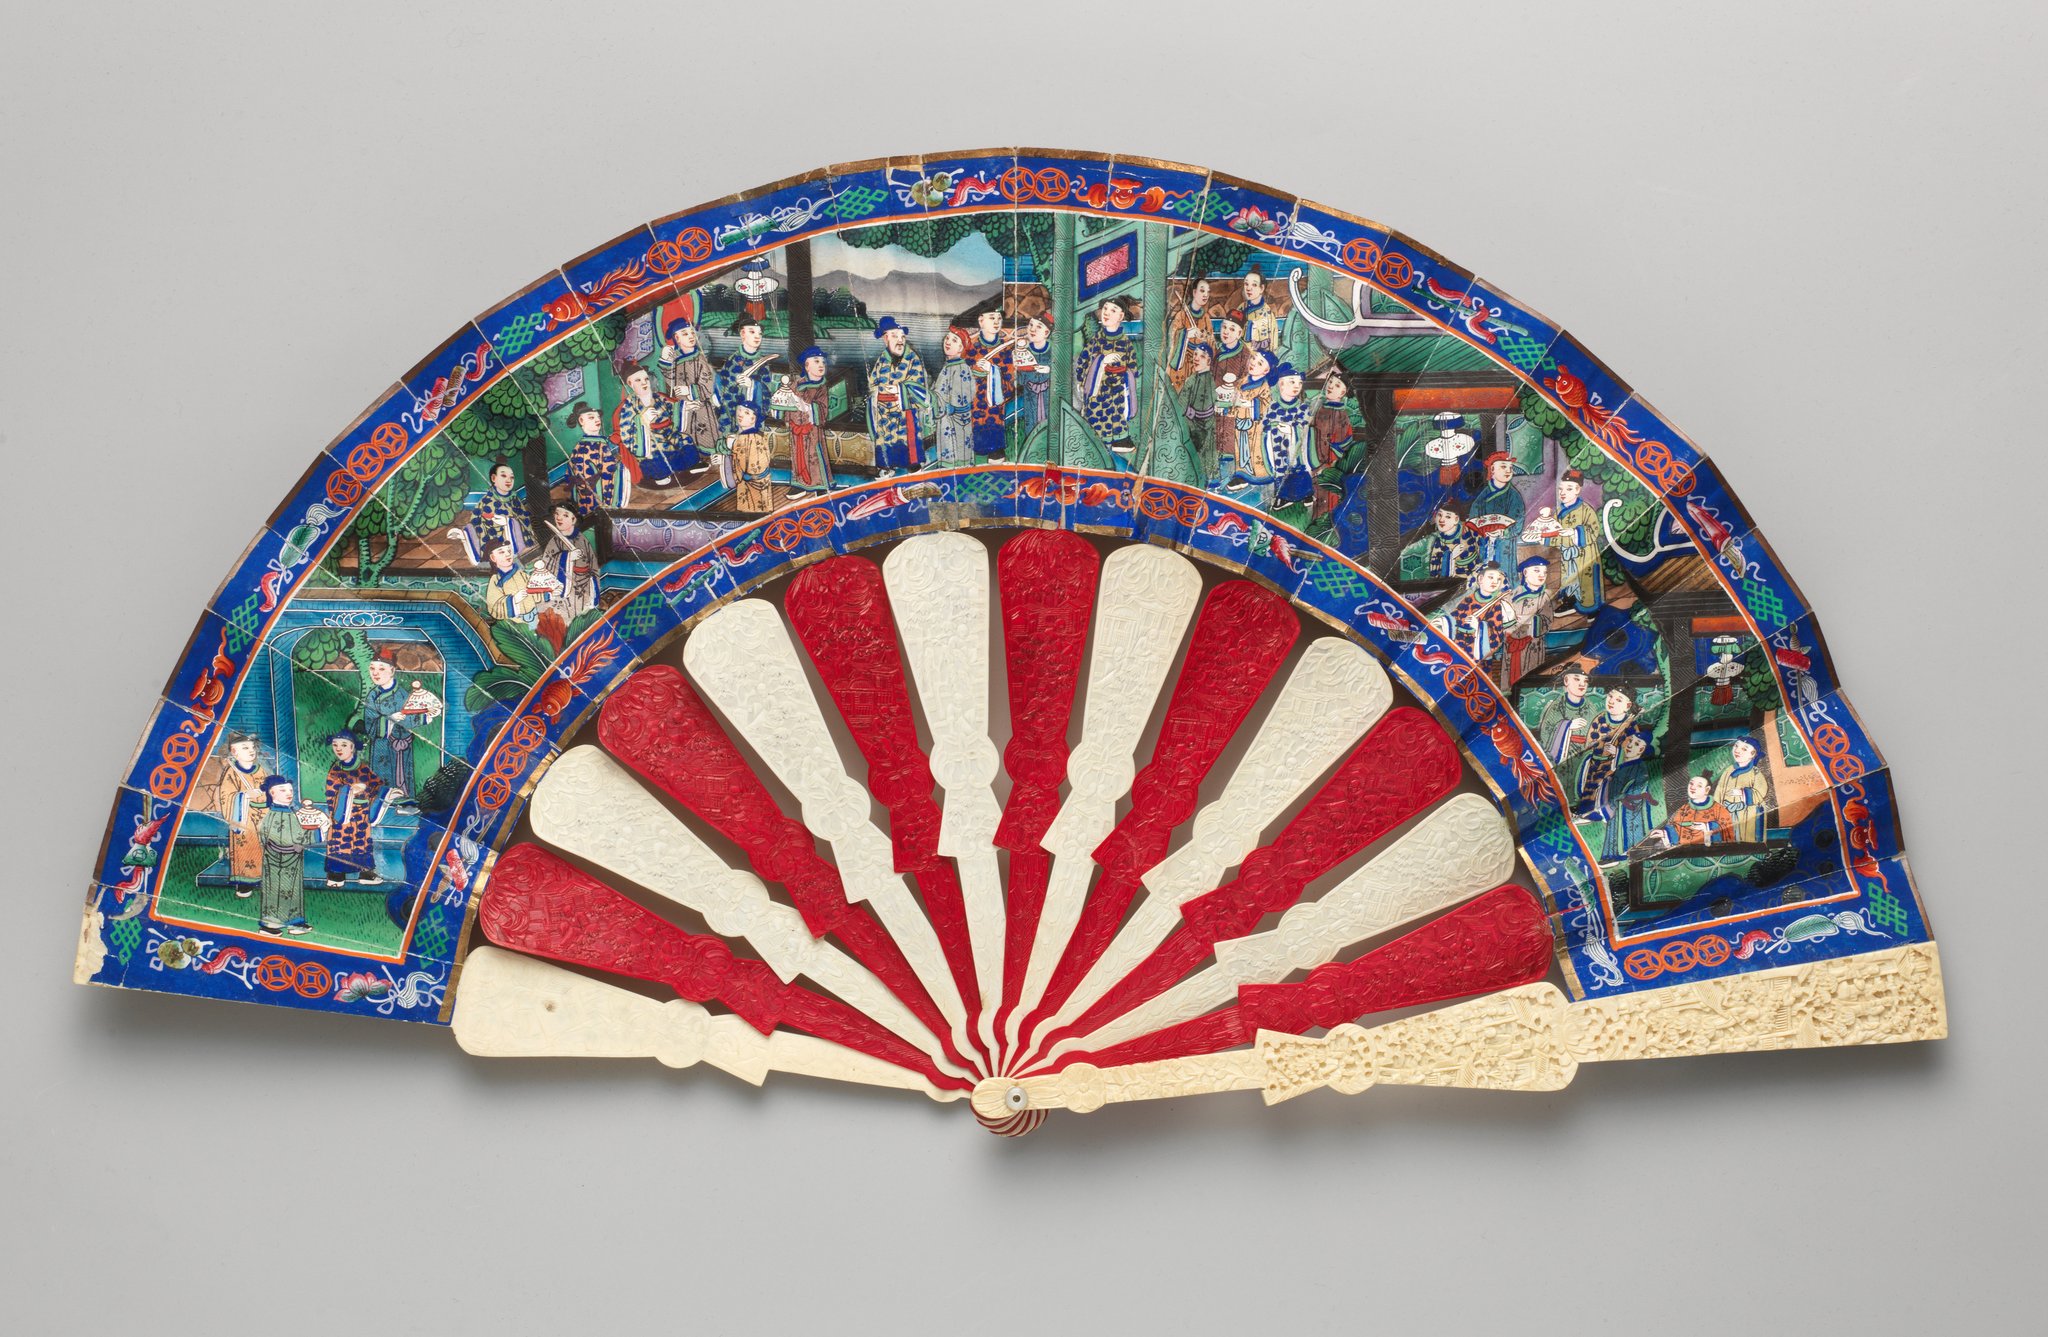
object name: fan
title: Folding Fan with Scene of Figures in a Courtyard Garden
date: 1801-1900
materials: ivory, paper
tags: men,women